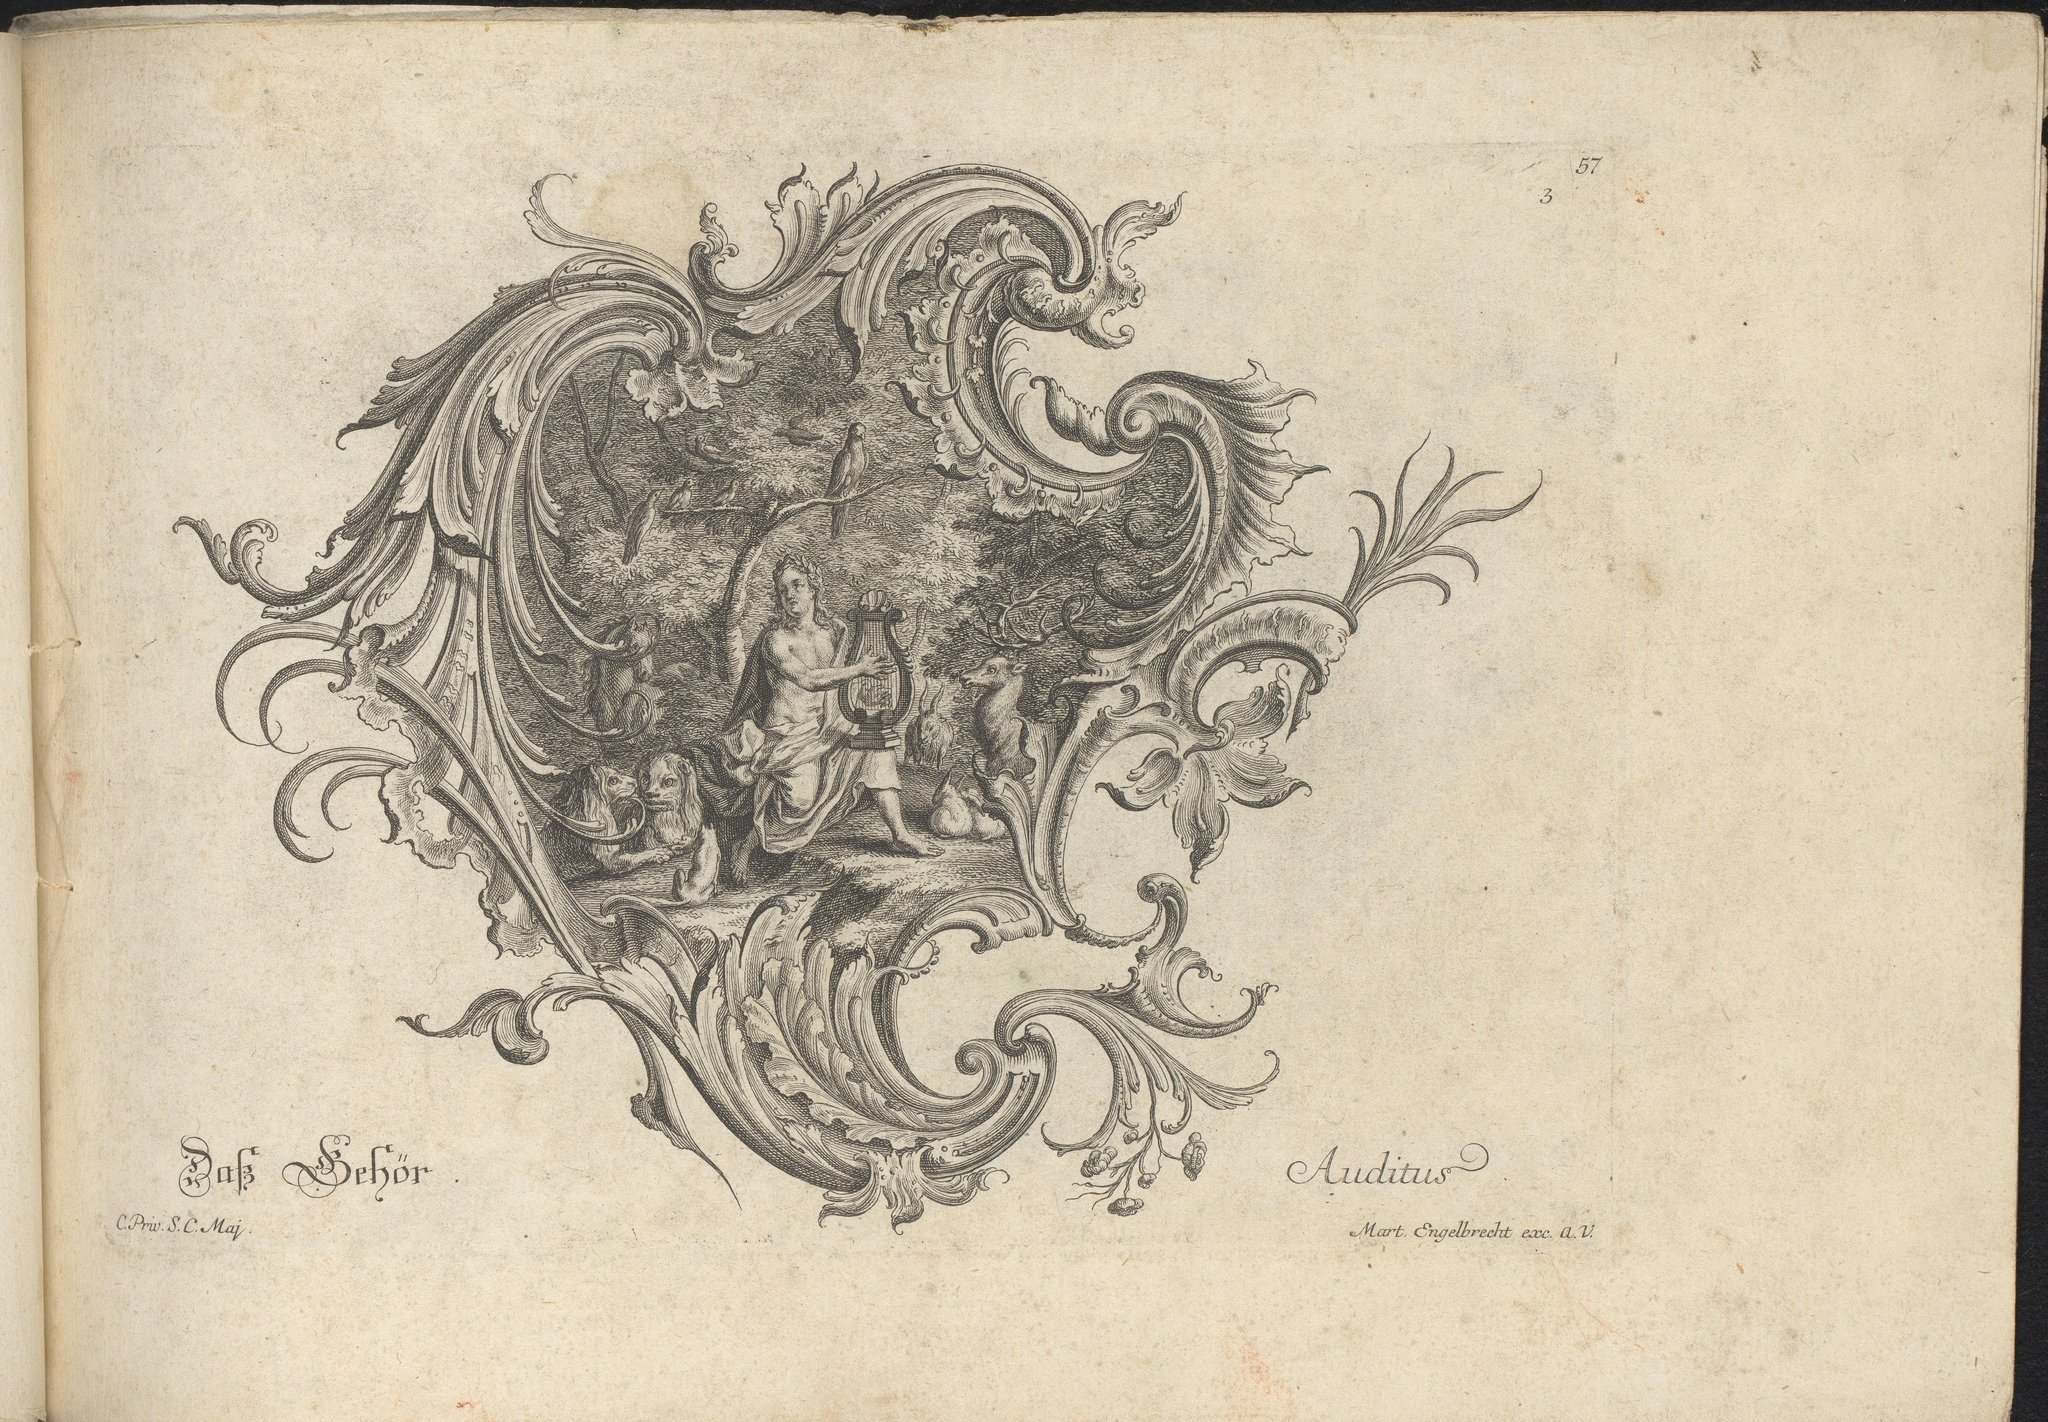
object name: ornament print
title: Neu Inventierte auf die artigste Facon Sehr nutzliche Schild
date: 1712-1755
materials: paper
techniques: etching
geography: augsburg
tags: hearing, listening (one of the five senses), orpheus playing the lyre: trees and rocks move, beasts and birds are enchanted, ornament ~ cartouche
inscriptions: collector's mark: Lugt 2228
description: Rocaille cartouche met een scène van Orpheus met lauwerkrans en lier in een boslandschap. Om hem heen zitten wilde dieren die naar zijn muziekspel op de lier luisteren. Prentnummer 57.